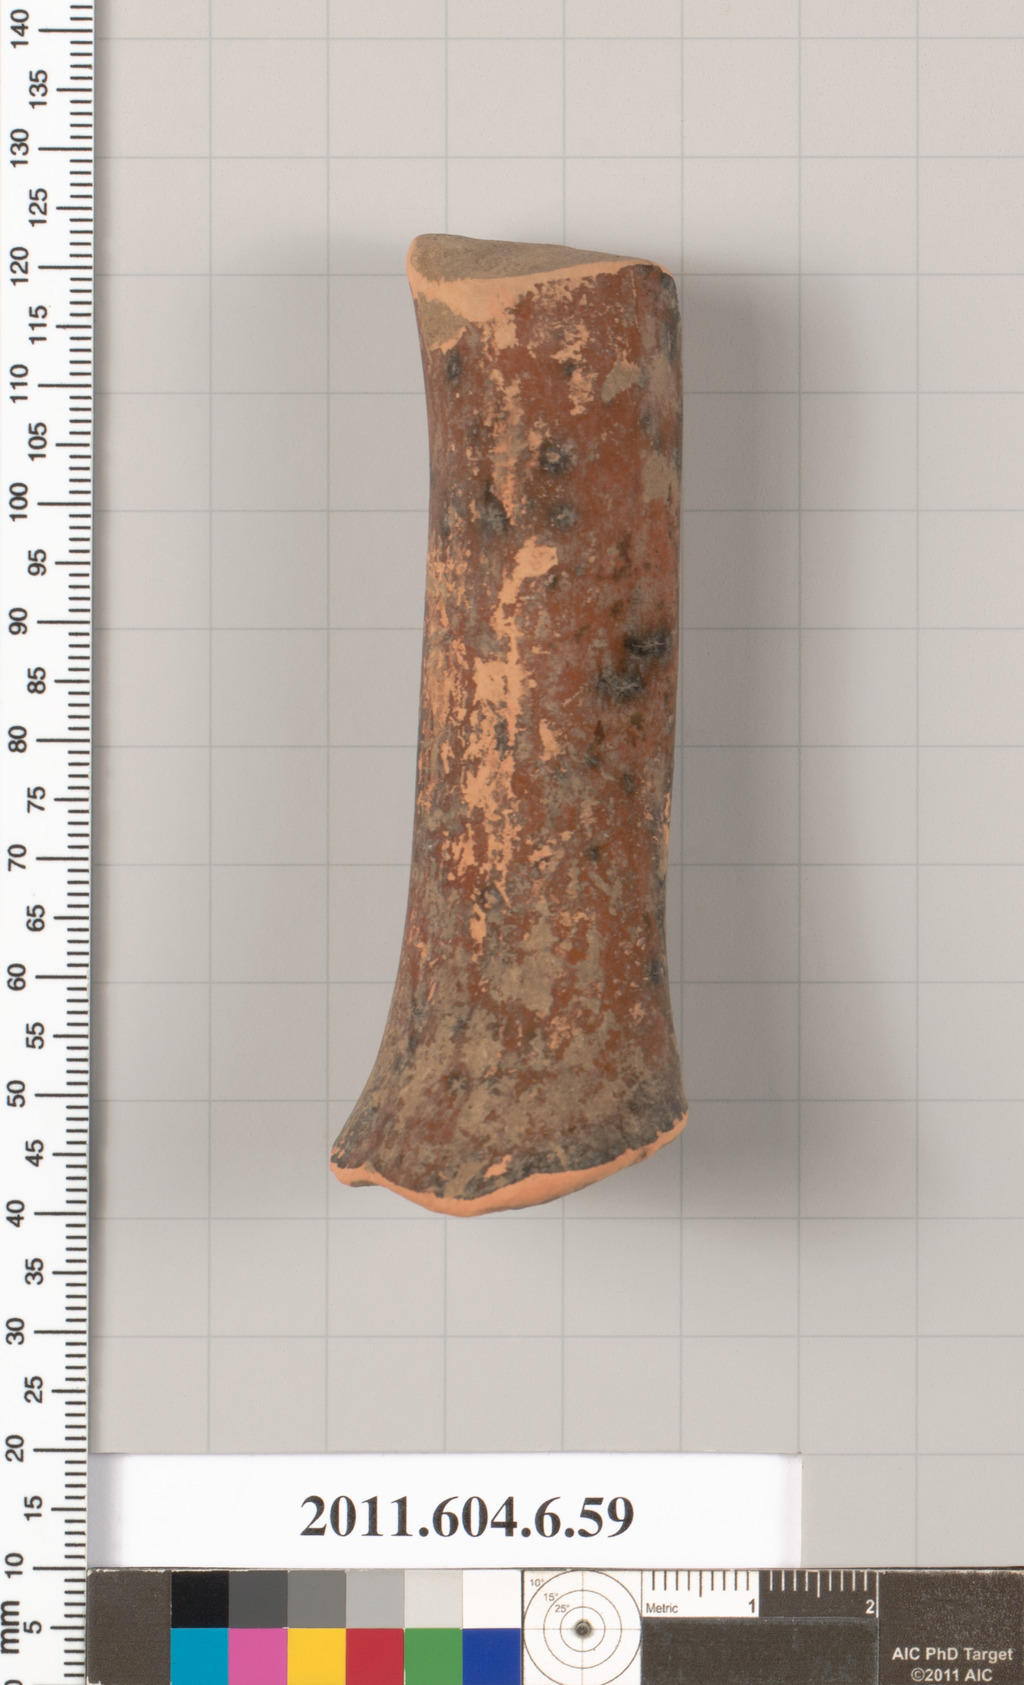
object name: krater fragment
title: Terracotta fragment of a column-krater (bowl for mixing wine and water)?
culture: greek, attic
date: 600-401 BCE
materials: terracotta